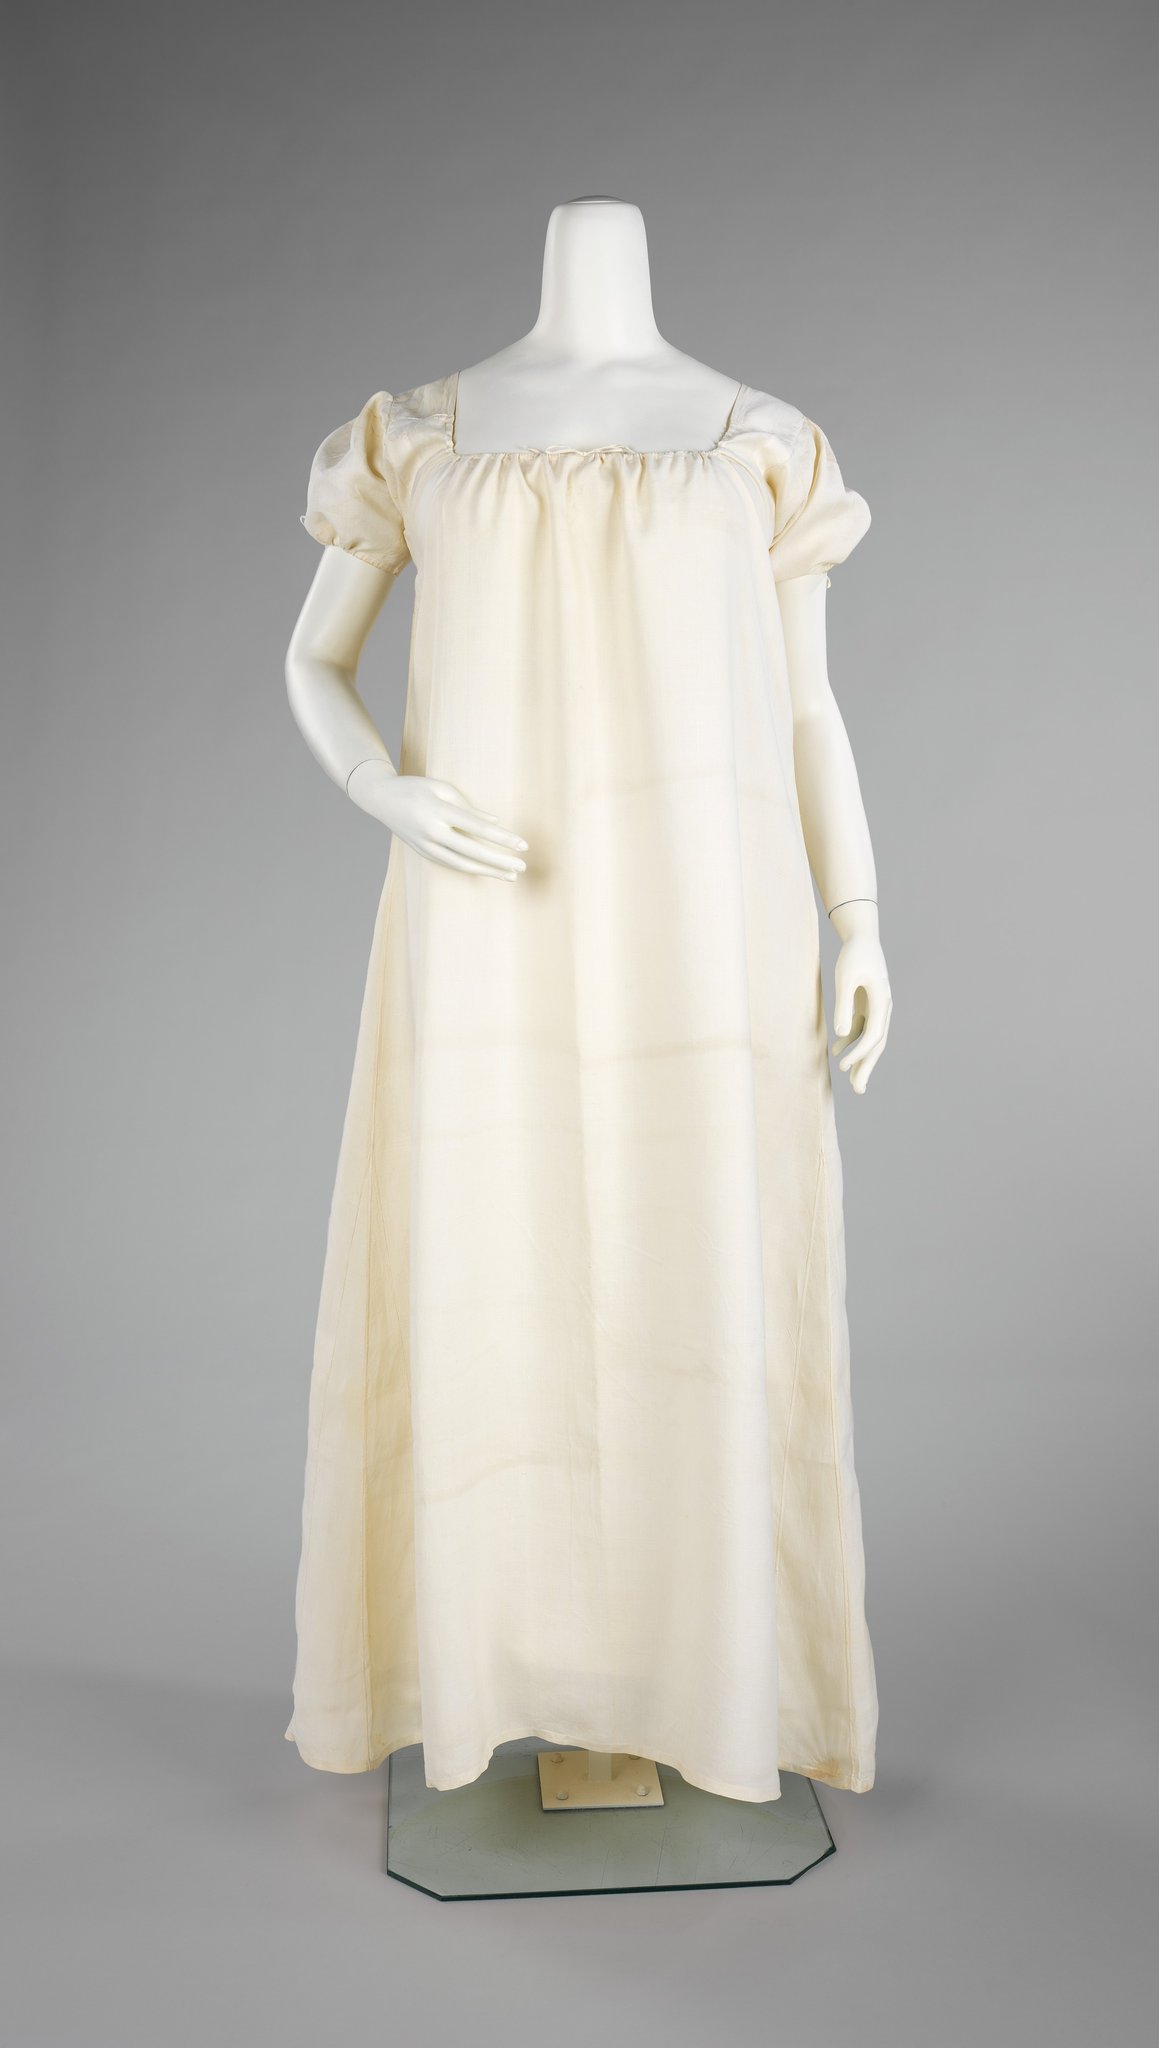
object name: chemise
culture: american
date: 1790-1810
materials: linen